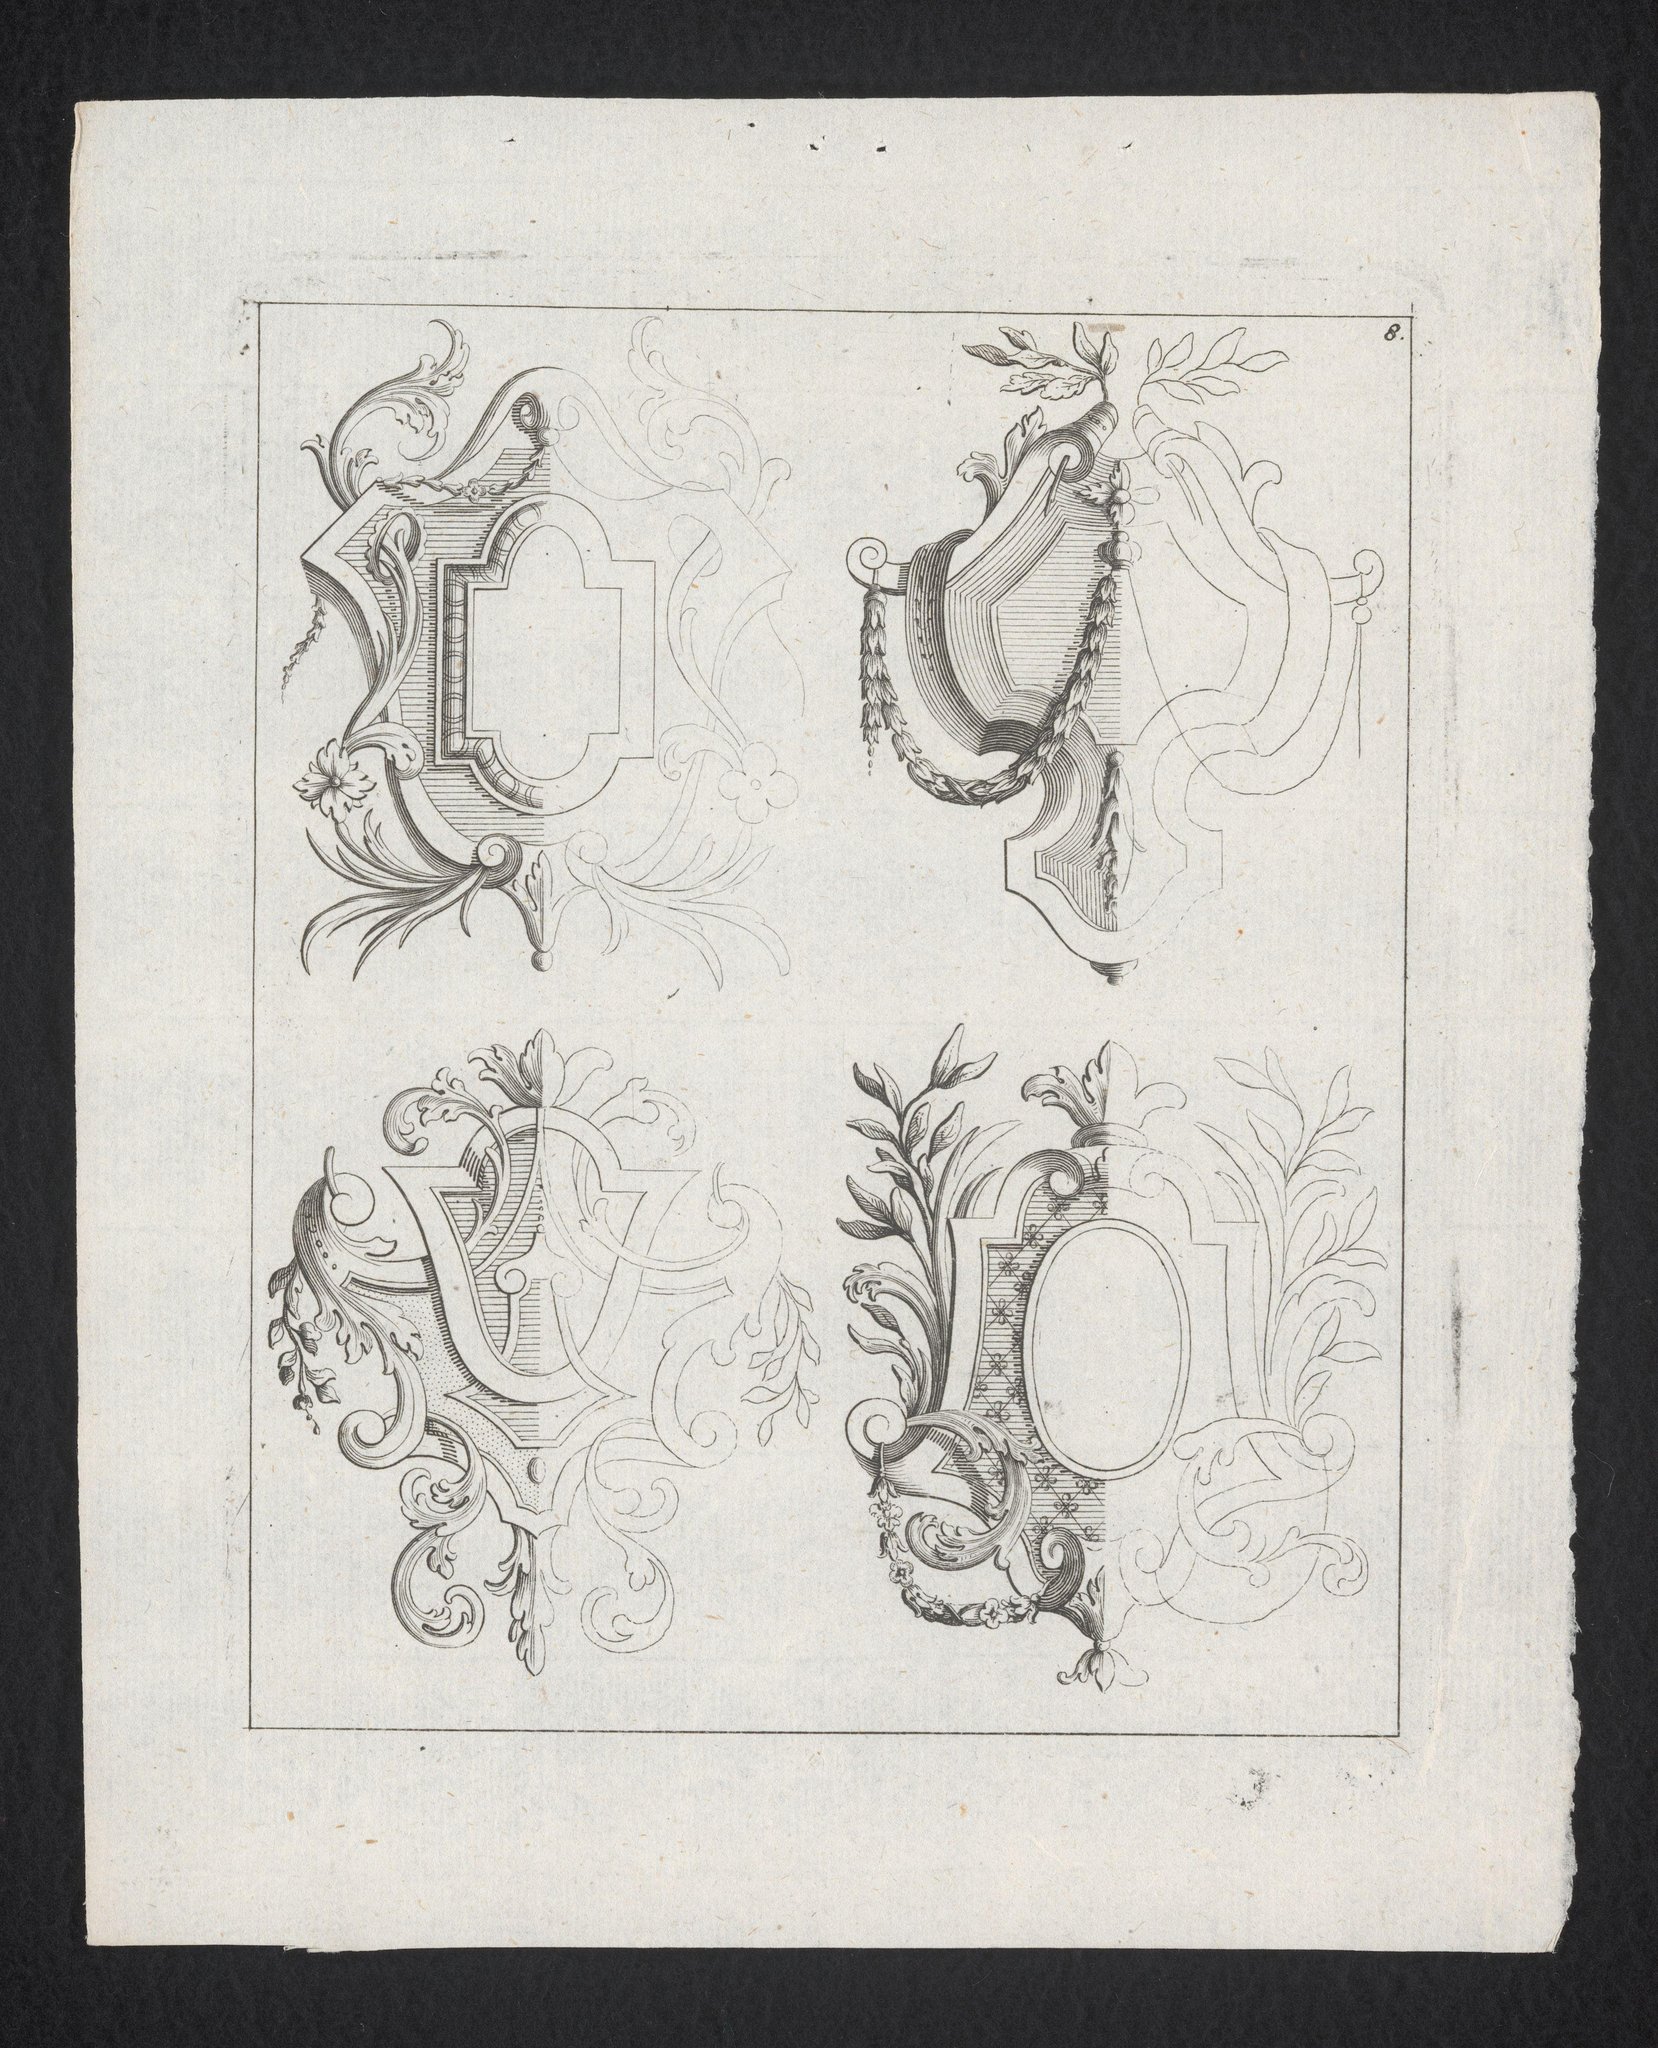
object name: print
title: II Anleitung zu Groteschen Schild und andern Verzierungen (...)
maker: Anonymous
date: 1704-1737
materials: paper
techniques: engraving, etching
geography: nuremberg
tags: 'laub- und bandelwerk' ~ ornament, ornament ~ cartouche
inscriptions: collector's mark: Lugt 2228, collector's mark: Lugt 2760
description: Drie rocaille cartouches en een decoratie met vlechtwerk, bladmotieven en guirlandes, met lijntekeningen.